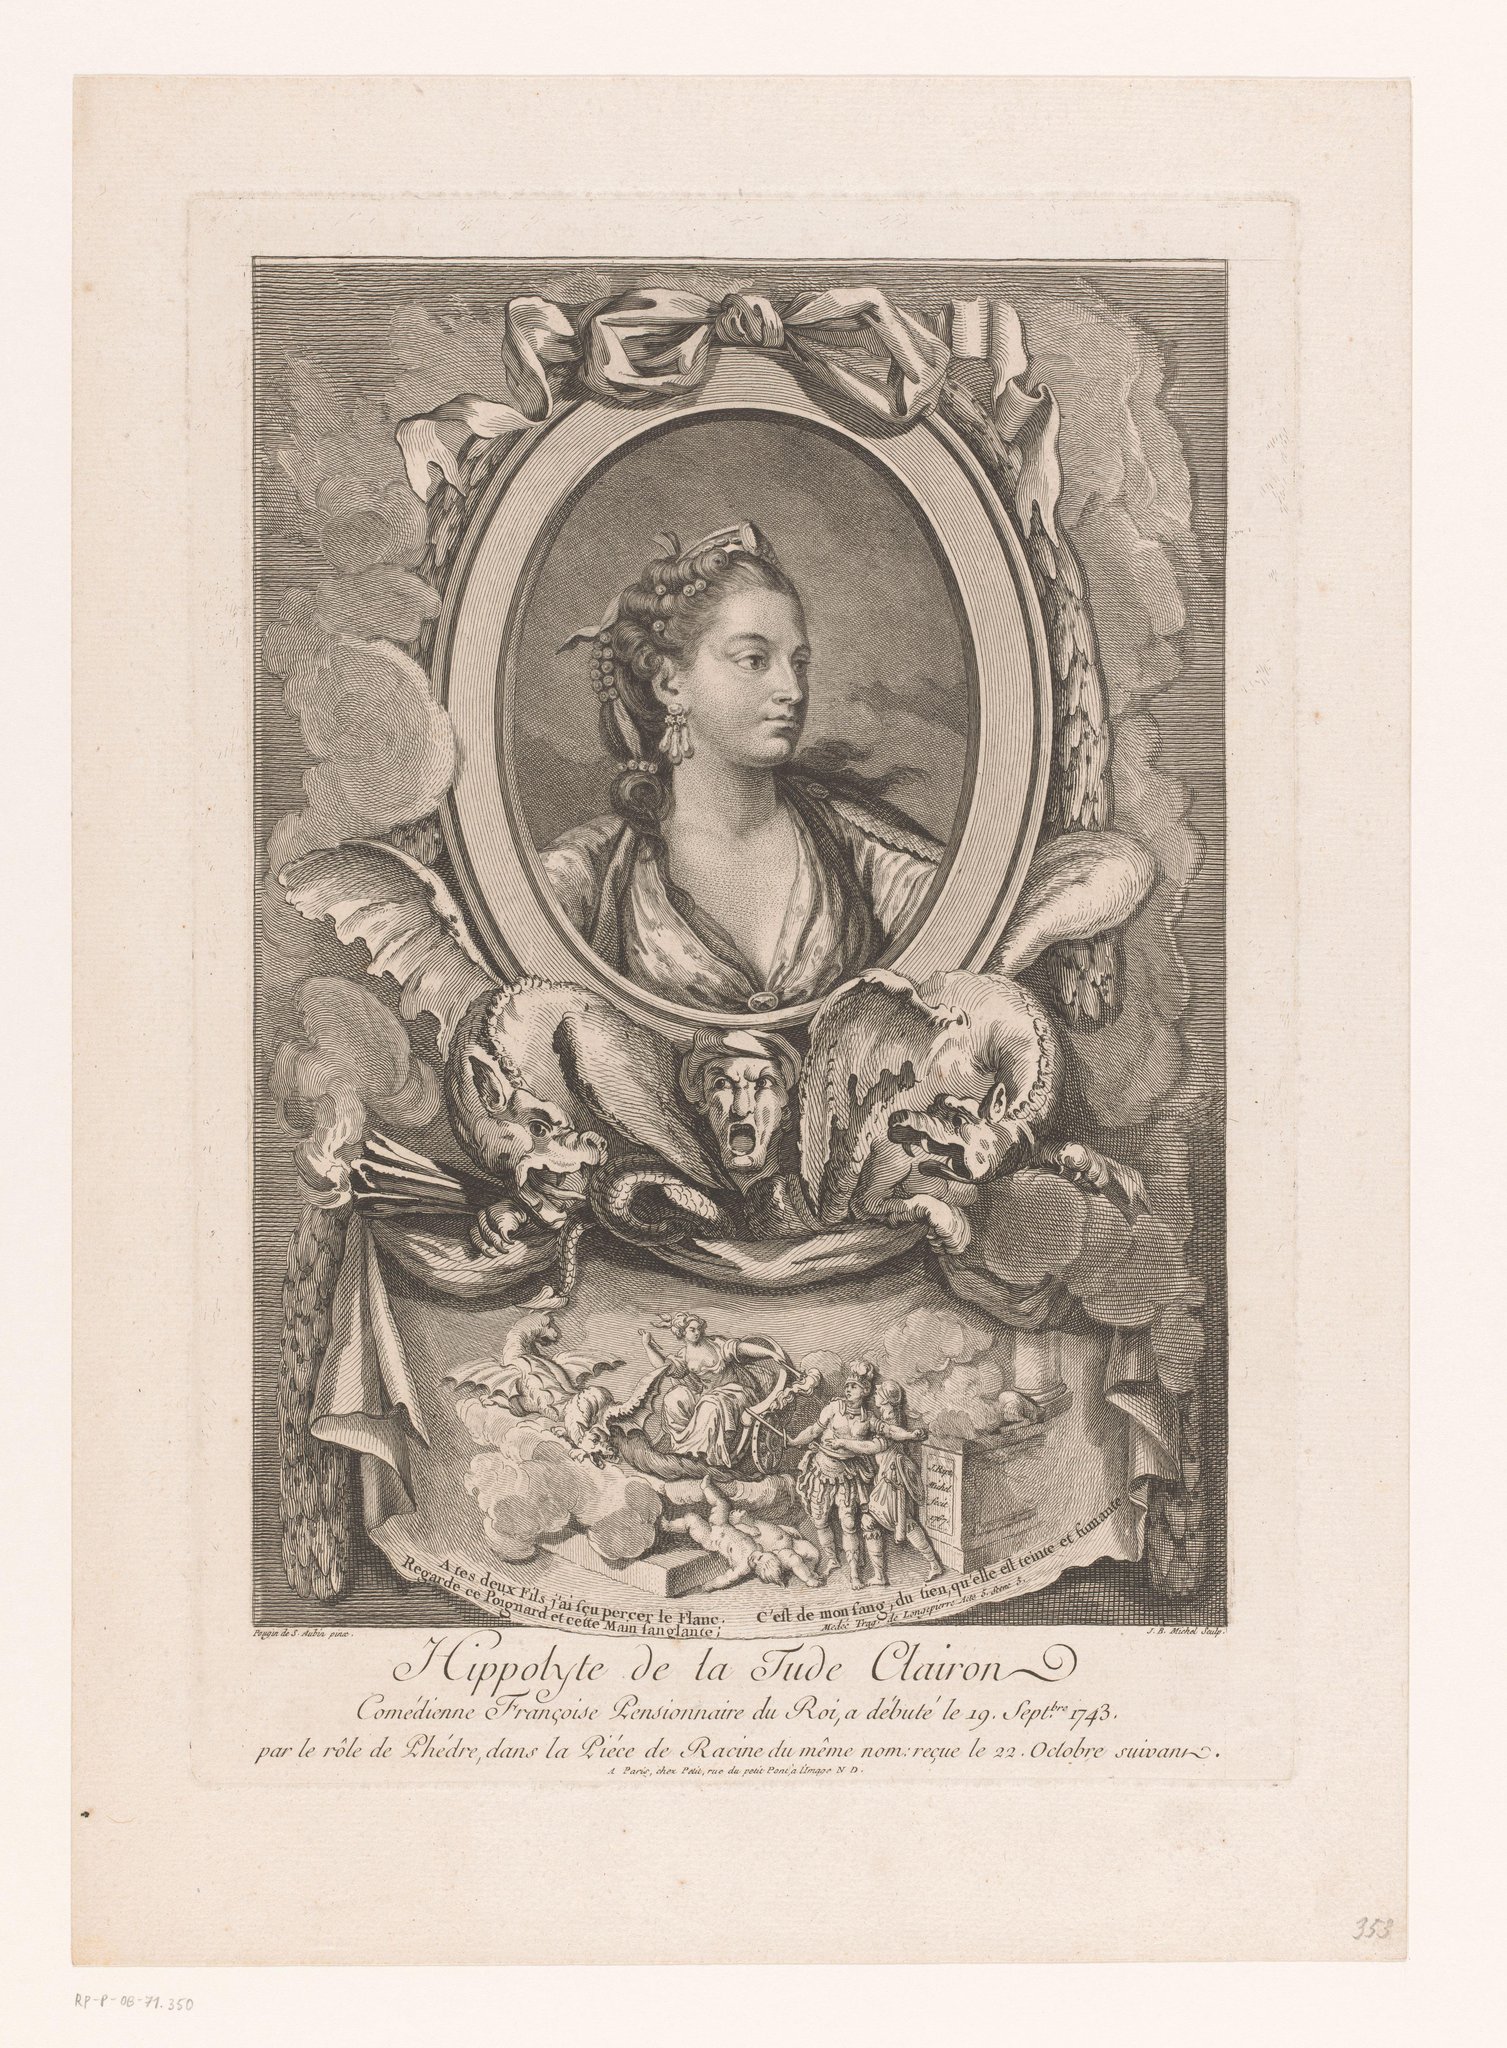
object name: print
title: Hippolyte de la Tude Clairon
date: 1767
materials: paper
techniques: engraving, etching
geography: paris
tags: historical persons - bb - woman, portrait of actor, actress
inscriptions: collector's mark: Lugt 2228